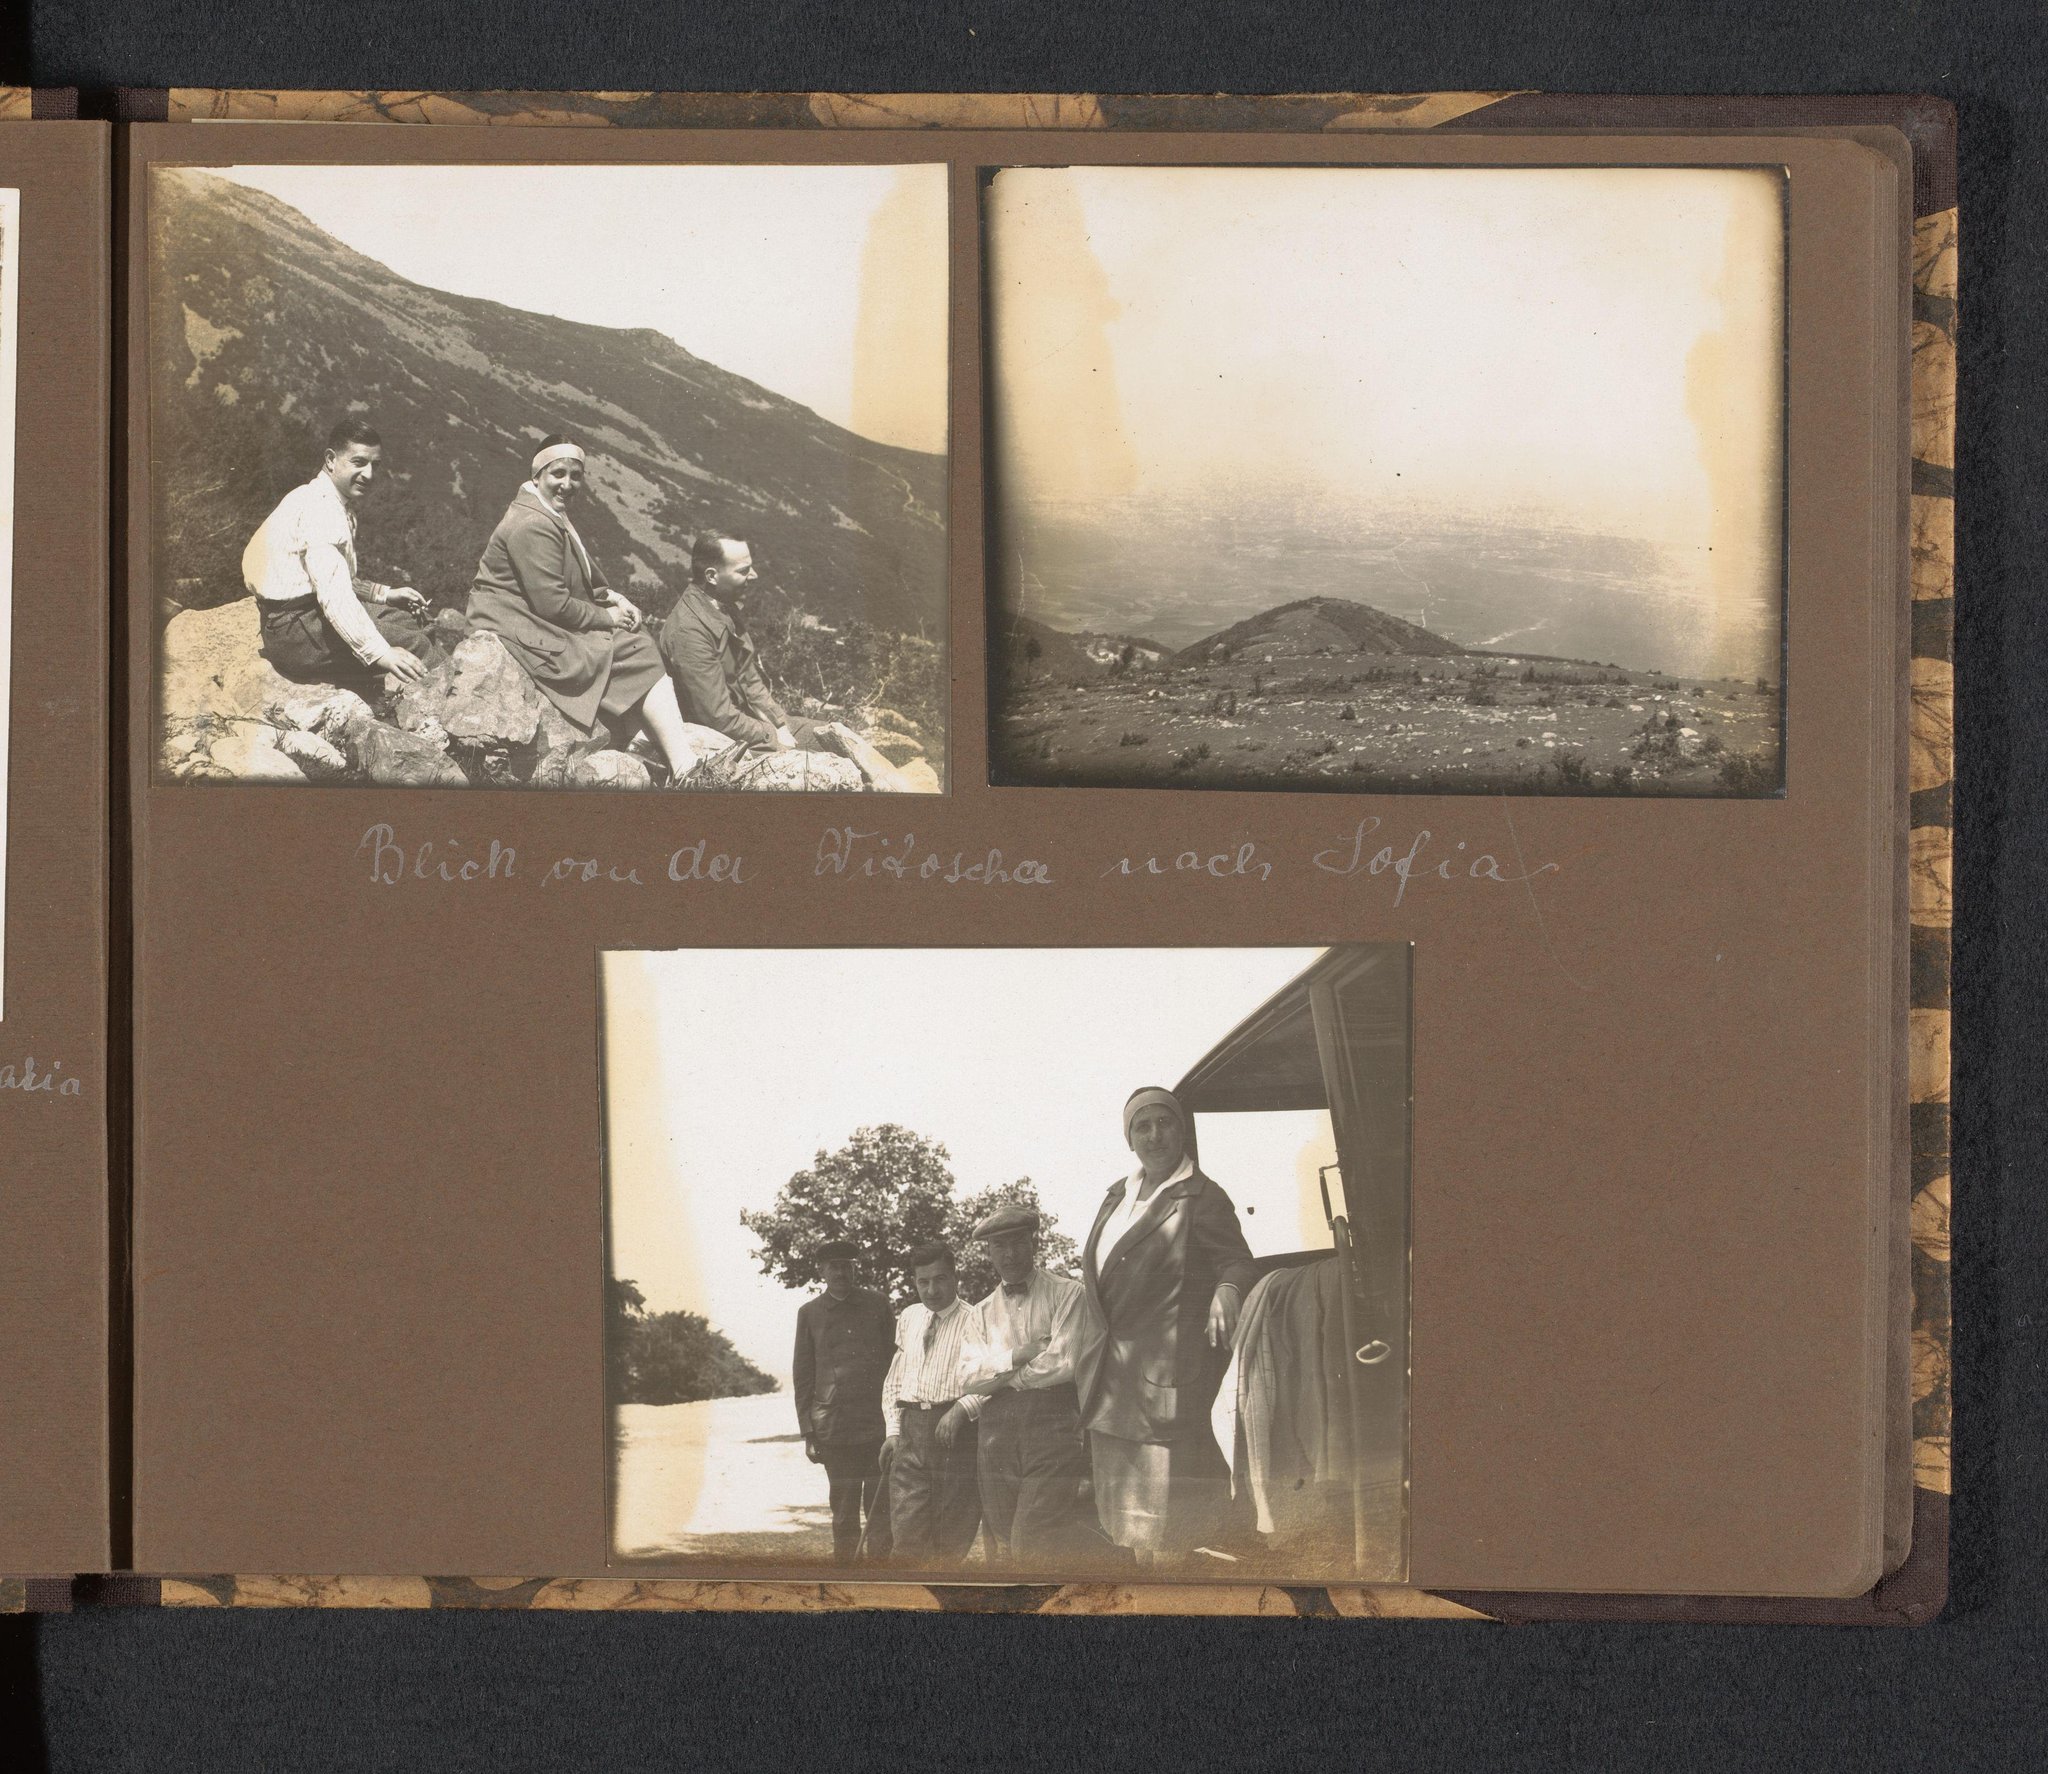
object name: photograph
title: Blik vanaf een Bulgaarse berg met daarop Else Wachenheimer-Moos en twee onbekende mannen, 1926-1927, in de buurt van Sofia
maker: else wachenheimer-moos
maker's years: 1895-1944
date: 1926-1927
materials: paper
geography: bulgaria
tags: else wachenheimer-moos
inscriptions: inscription: ‘Blick von der Witoscha nach Sofia’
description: Albumblad bevat drie foto's van Else Wachenheimer-Moos en drie onbekende mannen. Afkomstig uit album half formaat, kartonomslag met koordbinding en lichte veelvormige vormen op voorzijde.